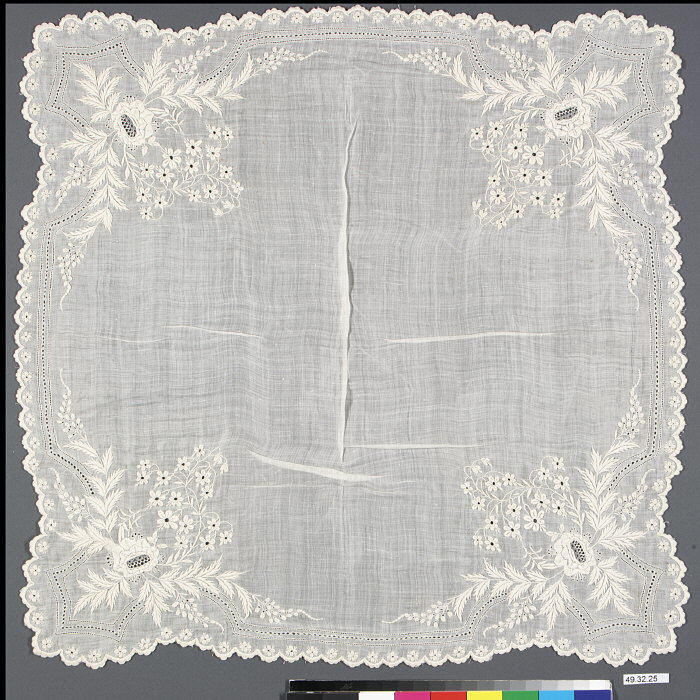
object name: handkerchief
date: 1840-1850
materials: cotton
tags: flowers